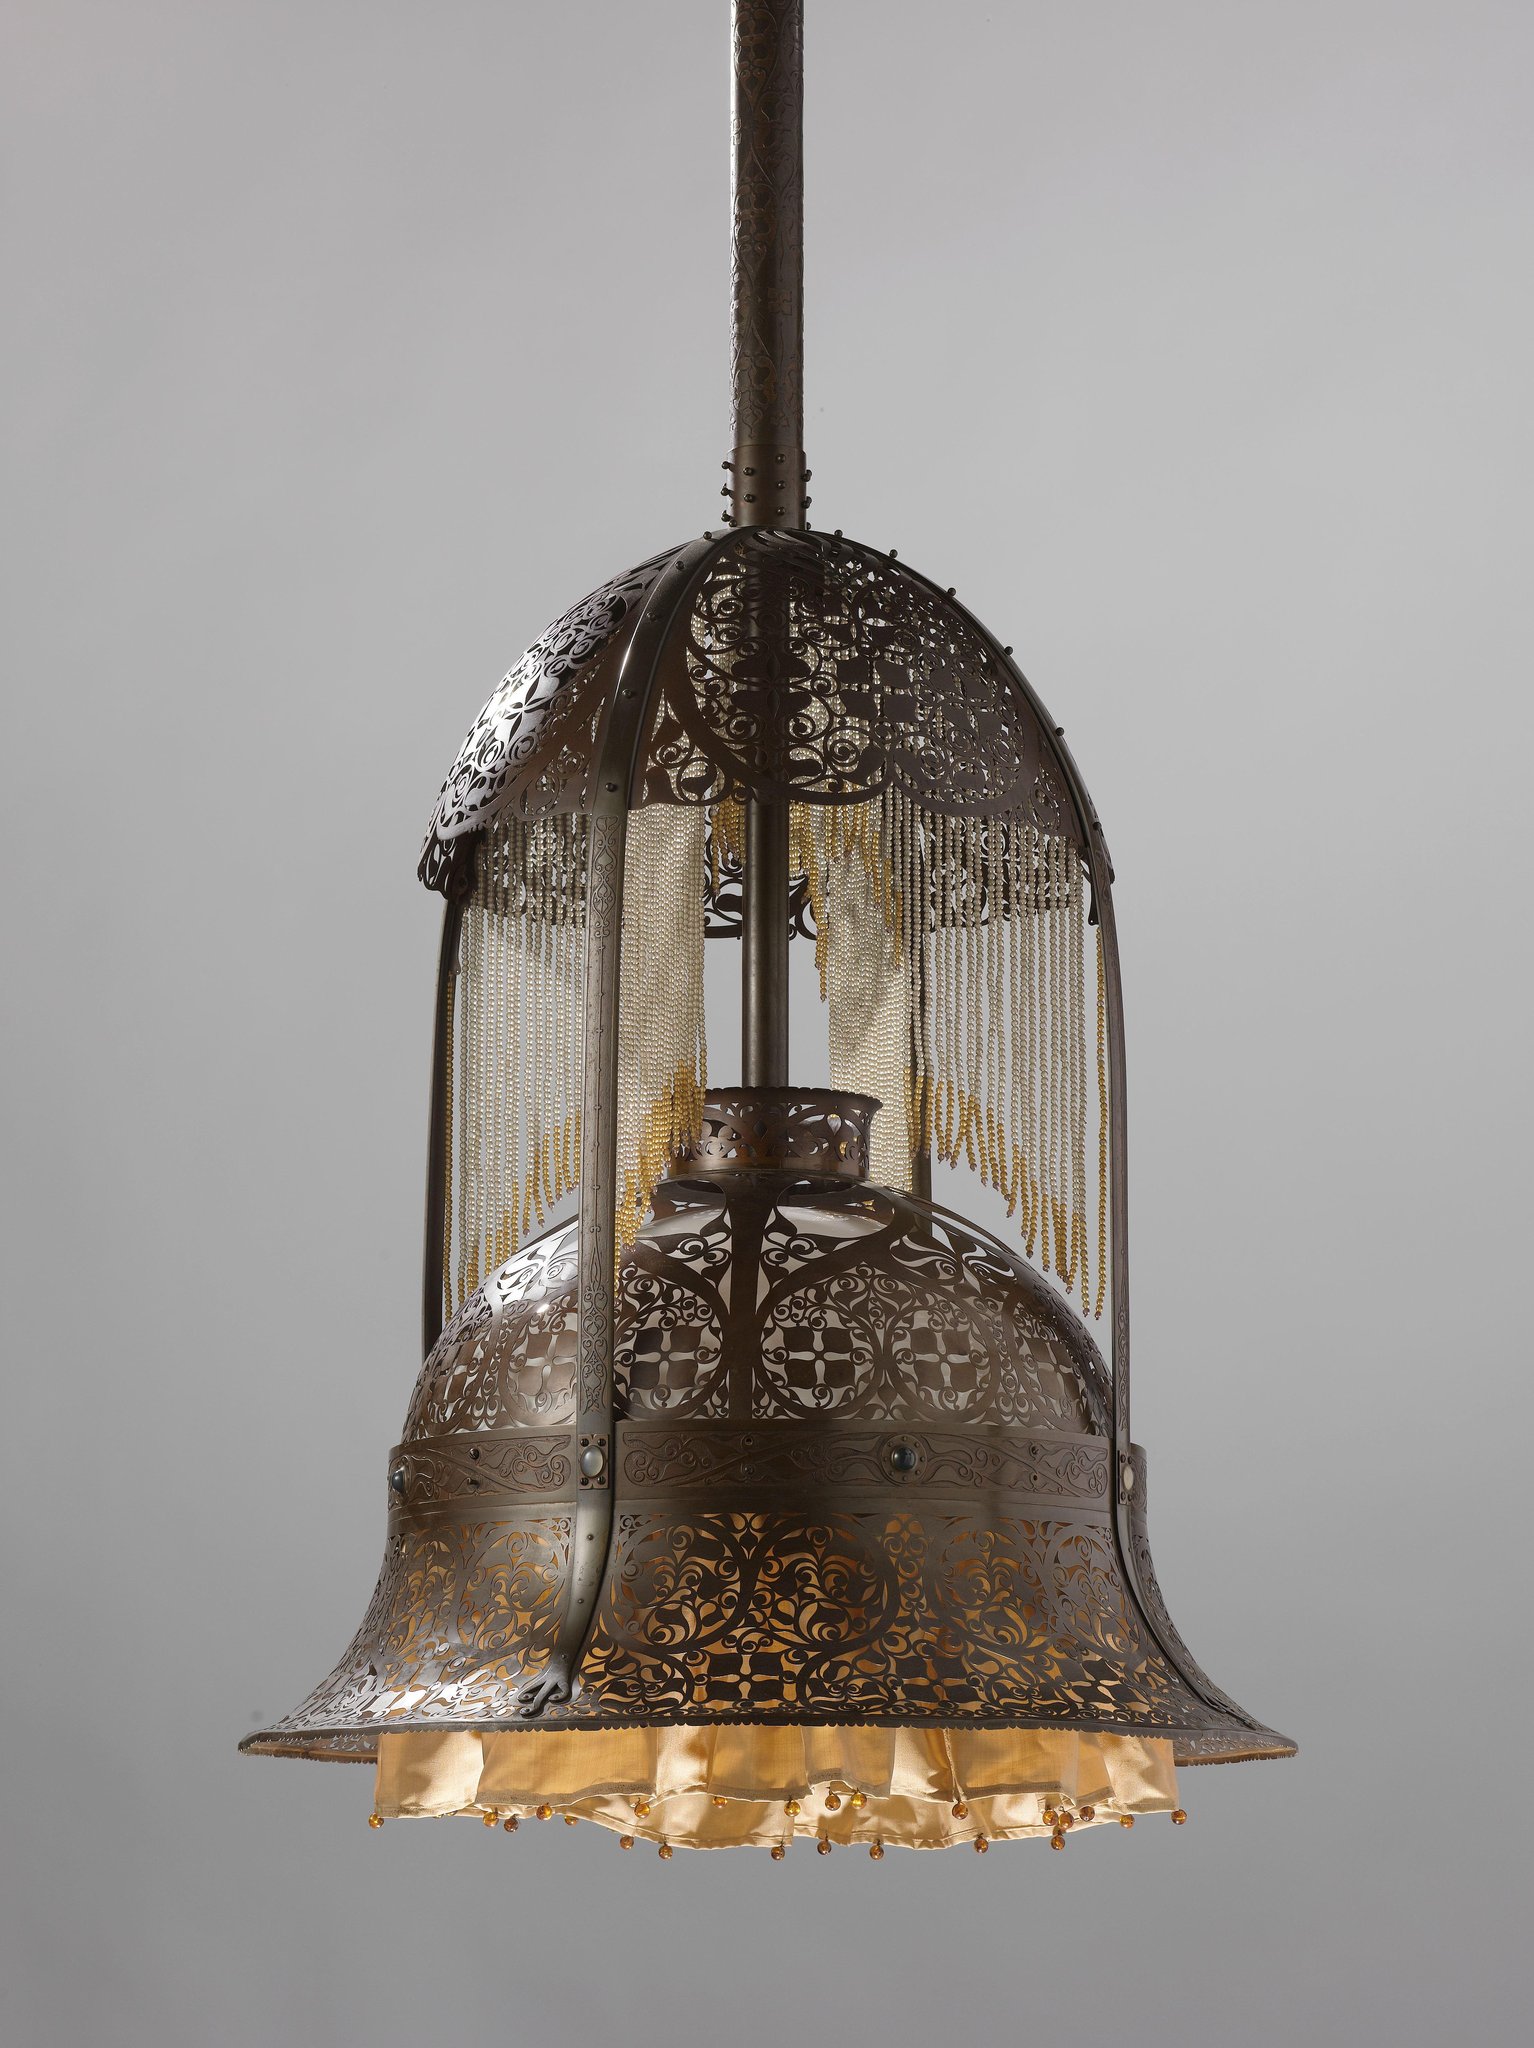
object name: hanging lamp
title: Eetkamerlamp van koper met een volant van glazen kraaltjes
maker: theo nieuwenhuis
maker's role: designer, draughtsman, print maker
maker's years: 1866-1951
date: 1914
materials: copper, glass, textile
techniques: etching, sawing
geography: amsterdam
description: Het voorwerp bestaat uit de eigenlijke uit twee delen en een ring samengestelde kap, die de electrische verlichting omvat, een aan vier stroken bevestigde decoratieve kap, een buis en een plafondstuk. De onderdelen zijn voorzien van geëtst en nagestoken of uitgezaagd rankenornament. Op de ring van de onderste kap zijn groene of matglazen stenen gemonteerd. Tegen de ornamentkap hangen snoeren met glazen kralen. Enkele jaren geleden zijn een nieuw montuur en een plalstic binnenkap aangebracht, alsmede een crêmekleurige met bruine glazen kraaltjes versierde volant.